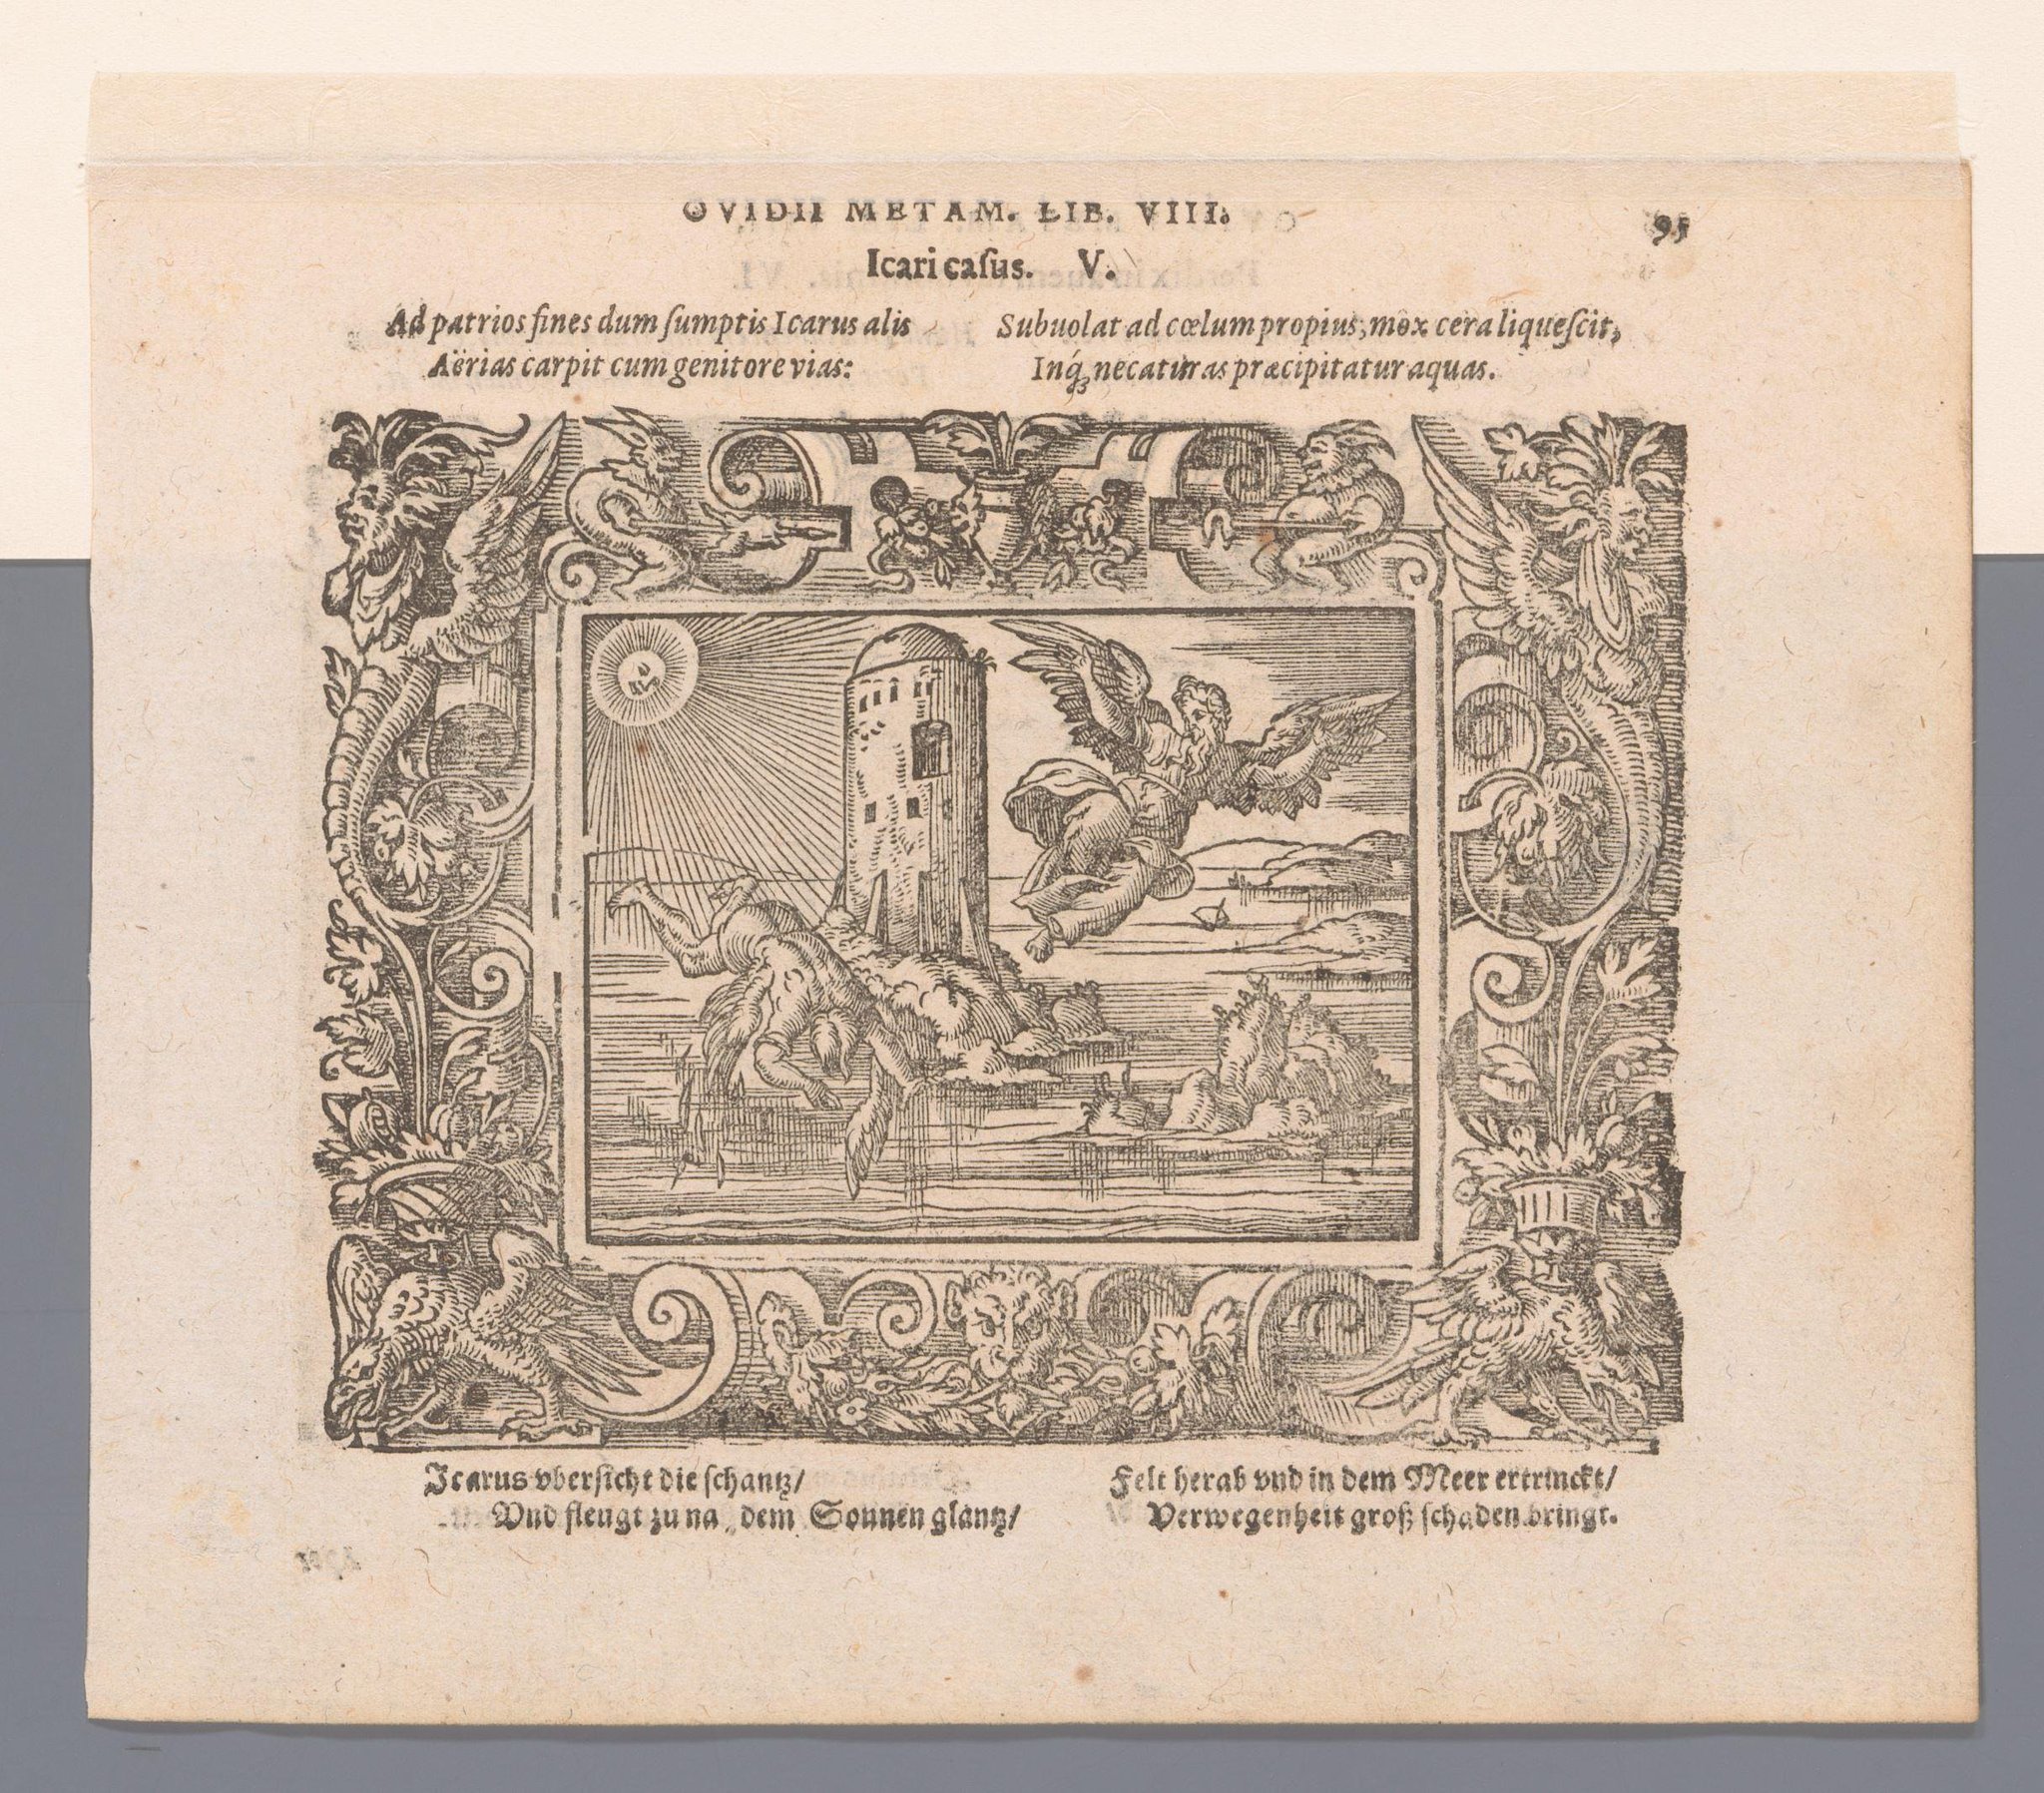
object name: book illustration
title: Val van Icarus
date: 1569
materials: paper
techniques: letterpress printing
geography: frankfurt am main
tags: scrollwork, strapwork ~ ornament, death i.e. the fall of icarus (daedalus present)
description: Illustratie bij de Metamorfosen van Ovidius, afkomstig uit de publicatie: Posthius, Johannes. Tetrasticha in Ovidii metam. Frankfurt am Main: Georg Rab en Sigmund Feyerabend en erven Weigand Han, 1569. De voorstellingen en ornamentranden van deze boekillustraties zijn van twee aparte blokken gedrukt. Beide werden afzonderlijk van elkaar ook gebruikt voor andere publicaties, en de ornamentranden werden eveneens binnen deze publicatie meerdere keren gebruikt.